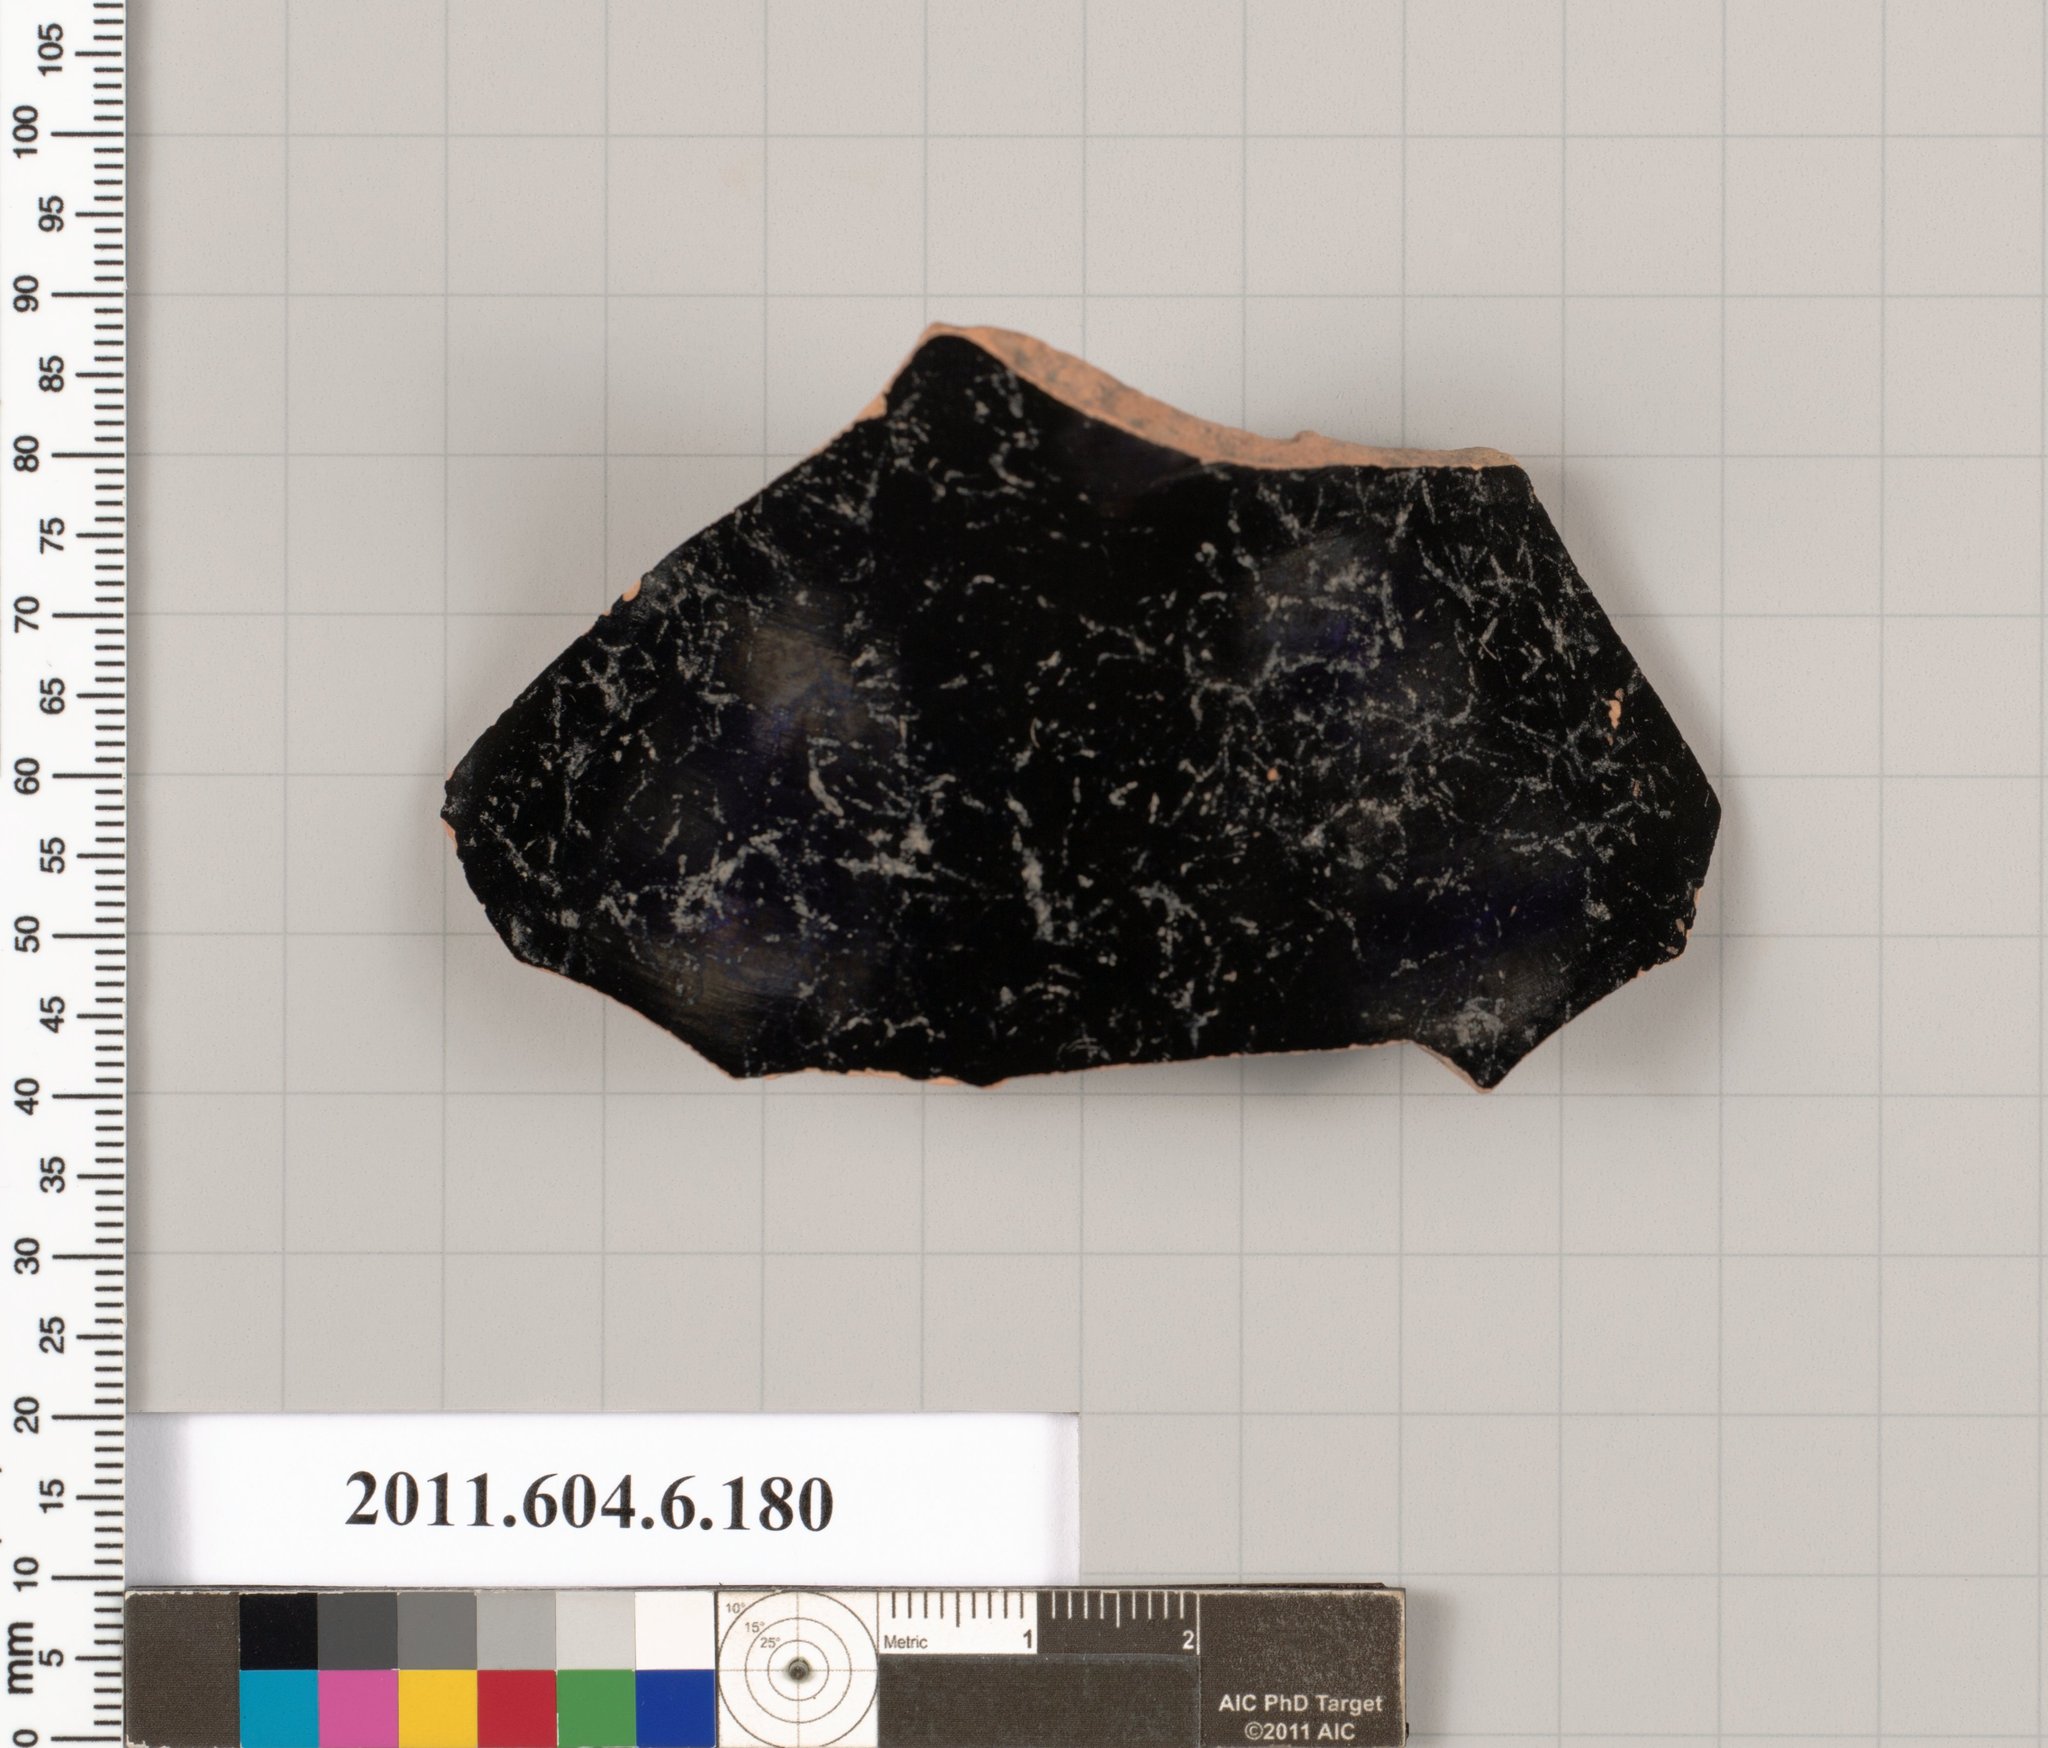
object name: oinochoe fragment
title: Terracotta fragment of an oinochoe (jug)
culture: greek, attic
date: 500-401 BCE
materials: terracotta